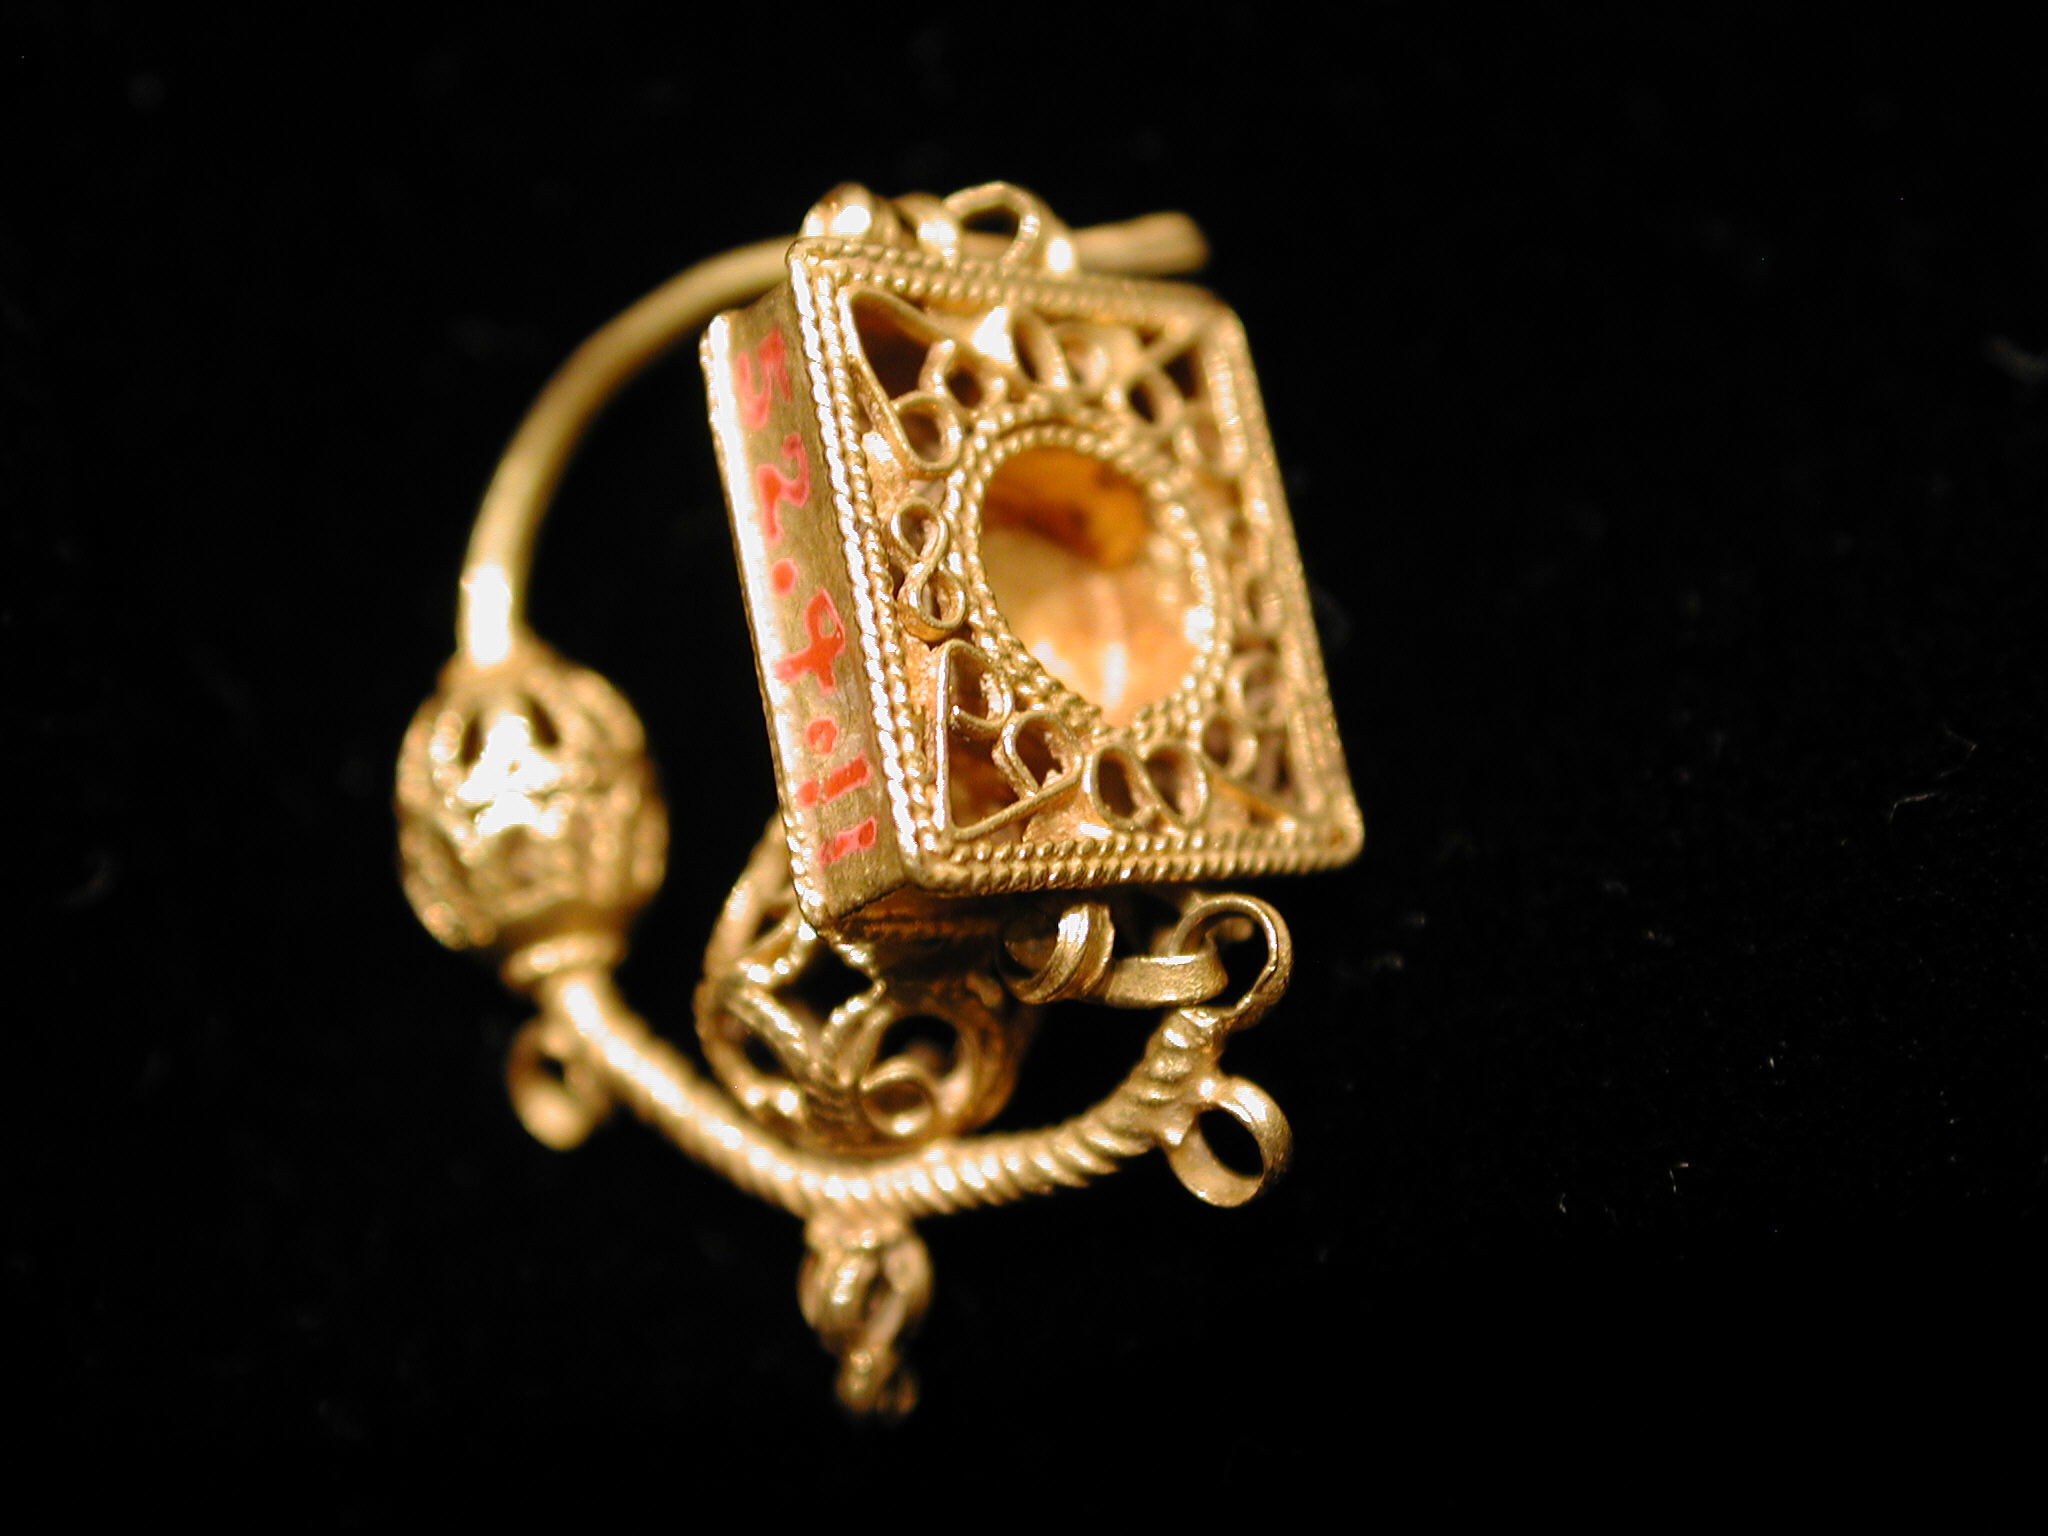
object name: earring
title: Earring, One of a pair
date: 1001-1200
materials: gold, metal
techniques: filigree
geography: iran